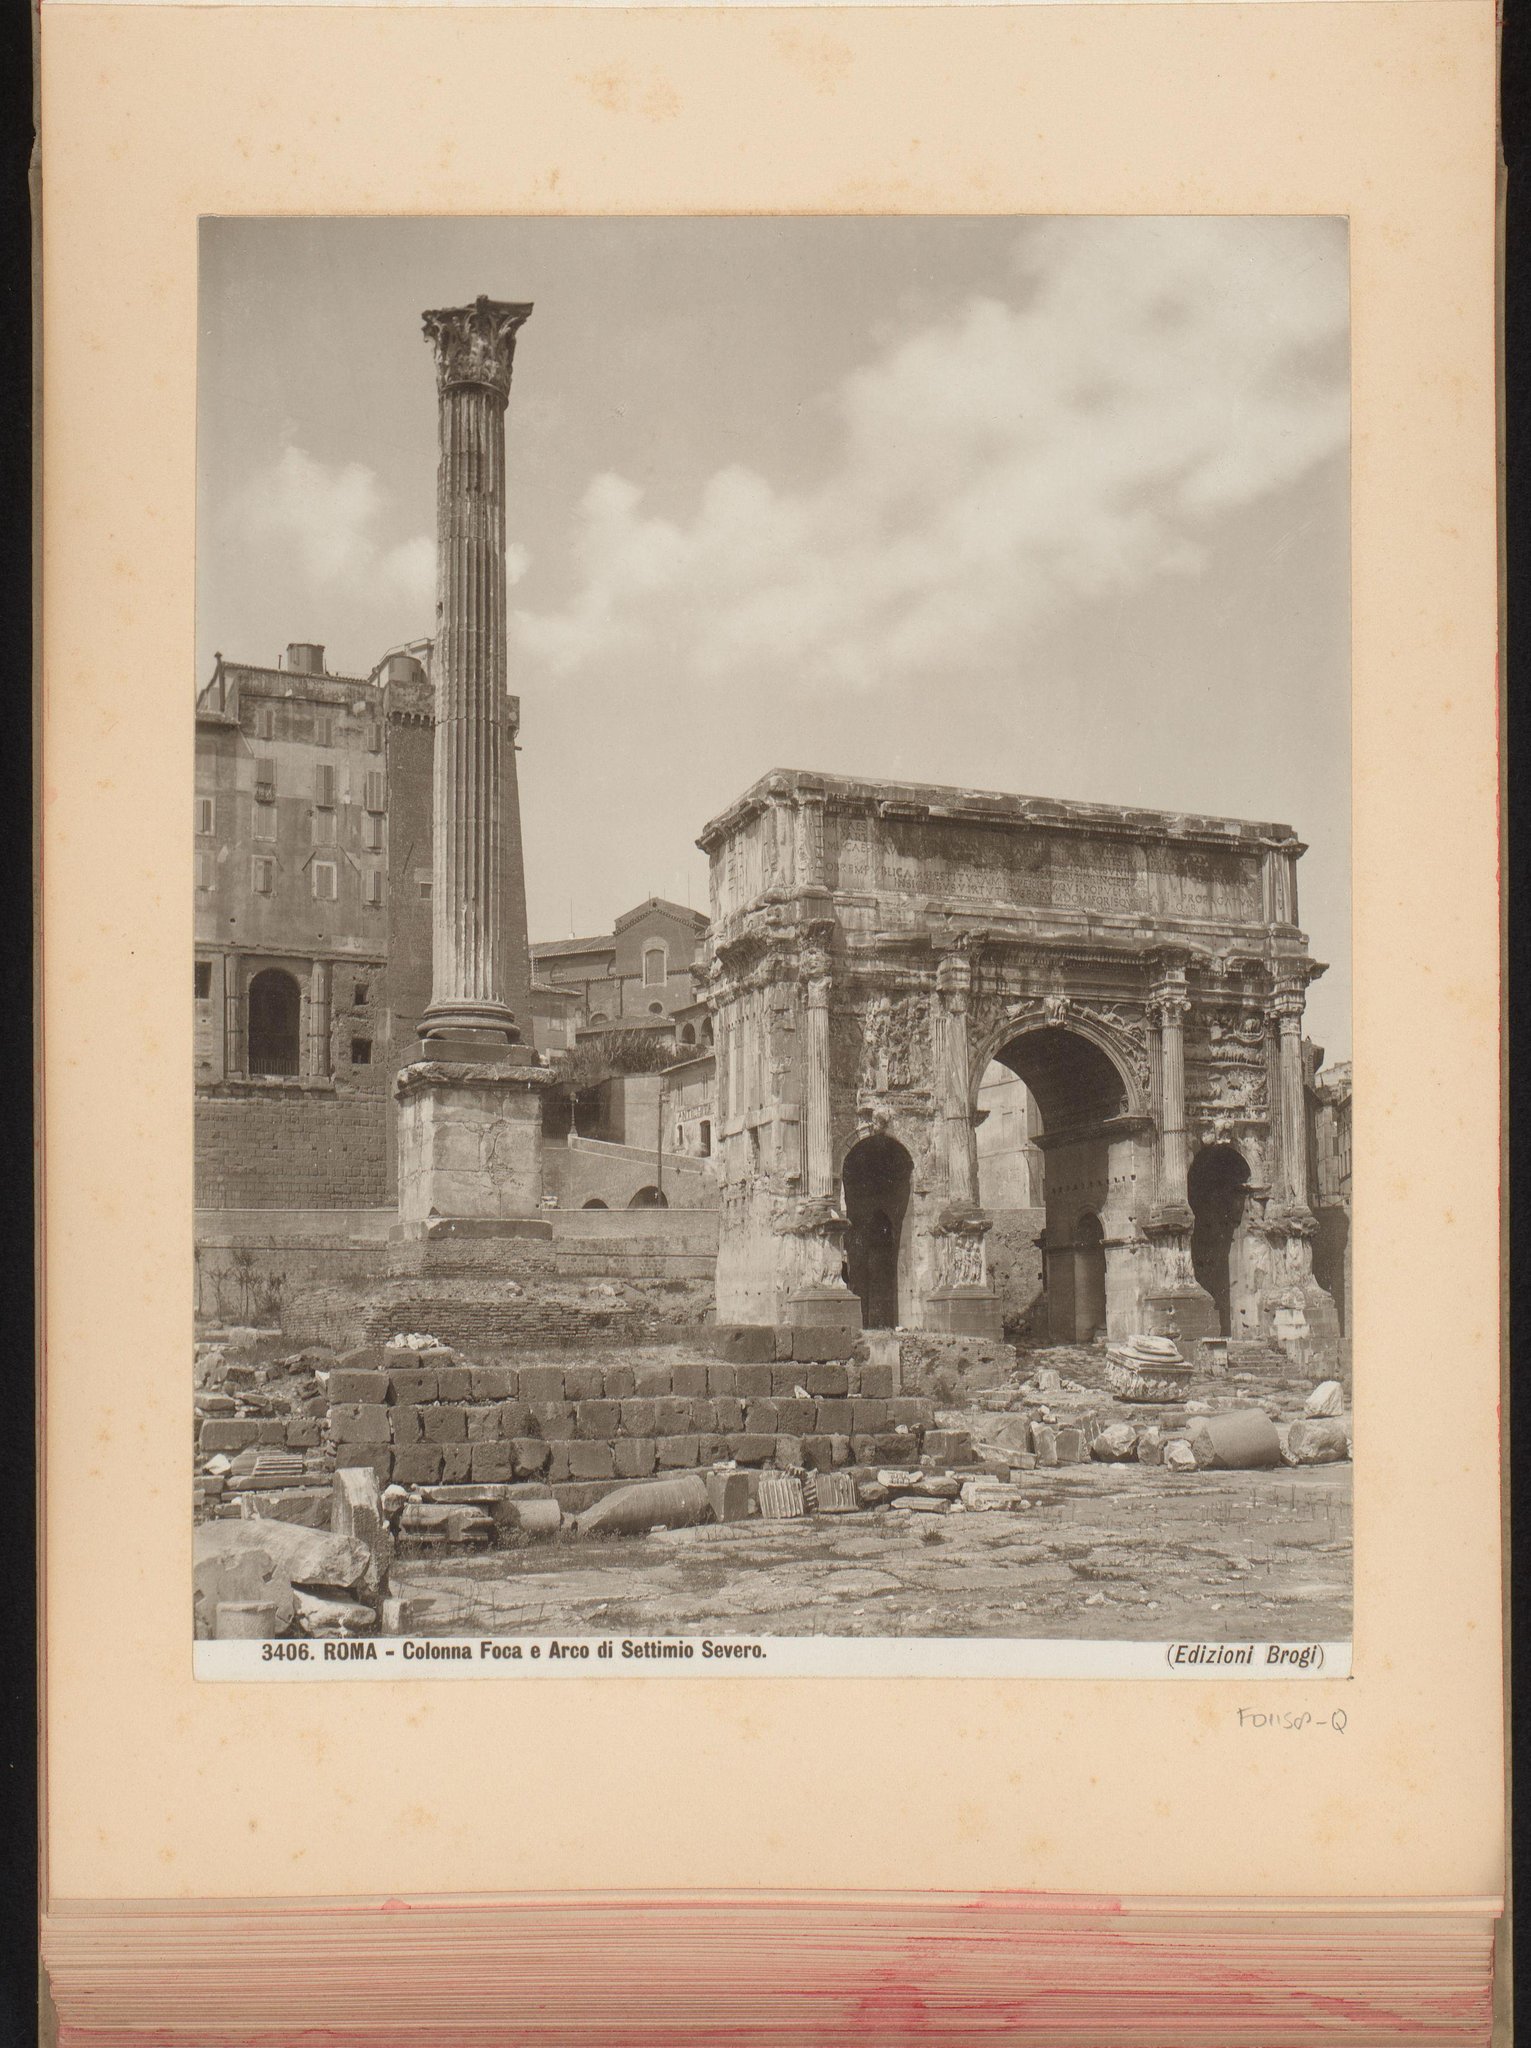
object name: photograph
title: Roma - Colonna Foca e Arco di Settimo Severo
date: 1875-1907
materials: photographic support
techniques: gelatin silver print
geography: forum romanum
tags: column, pillar ~ architecture, triumphal arch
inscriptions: number: ‘3406’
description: Onderdeel van Fotoalbum met opnames van bezienswaardigheden en kunstwerken in Italië.